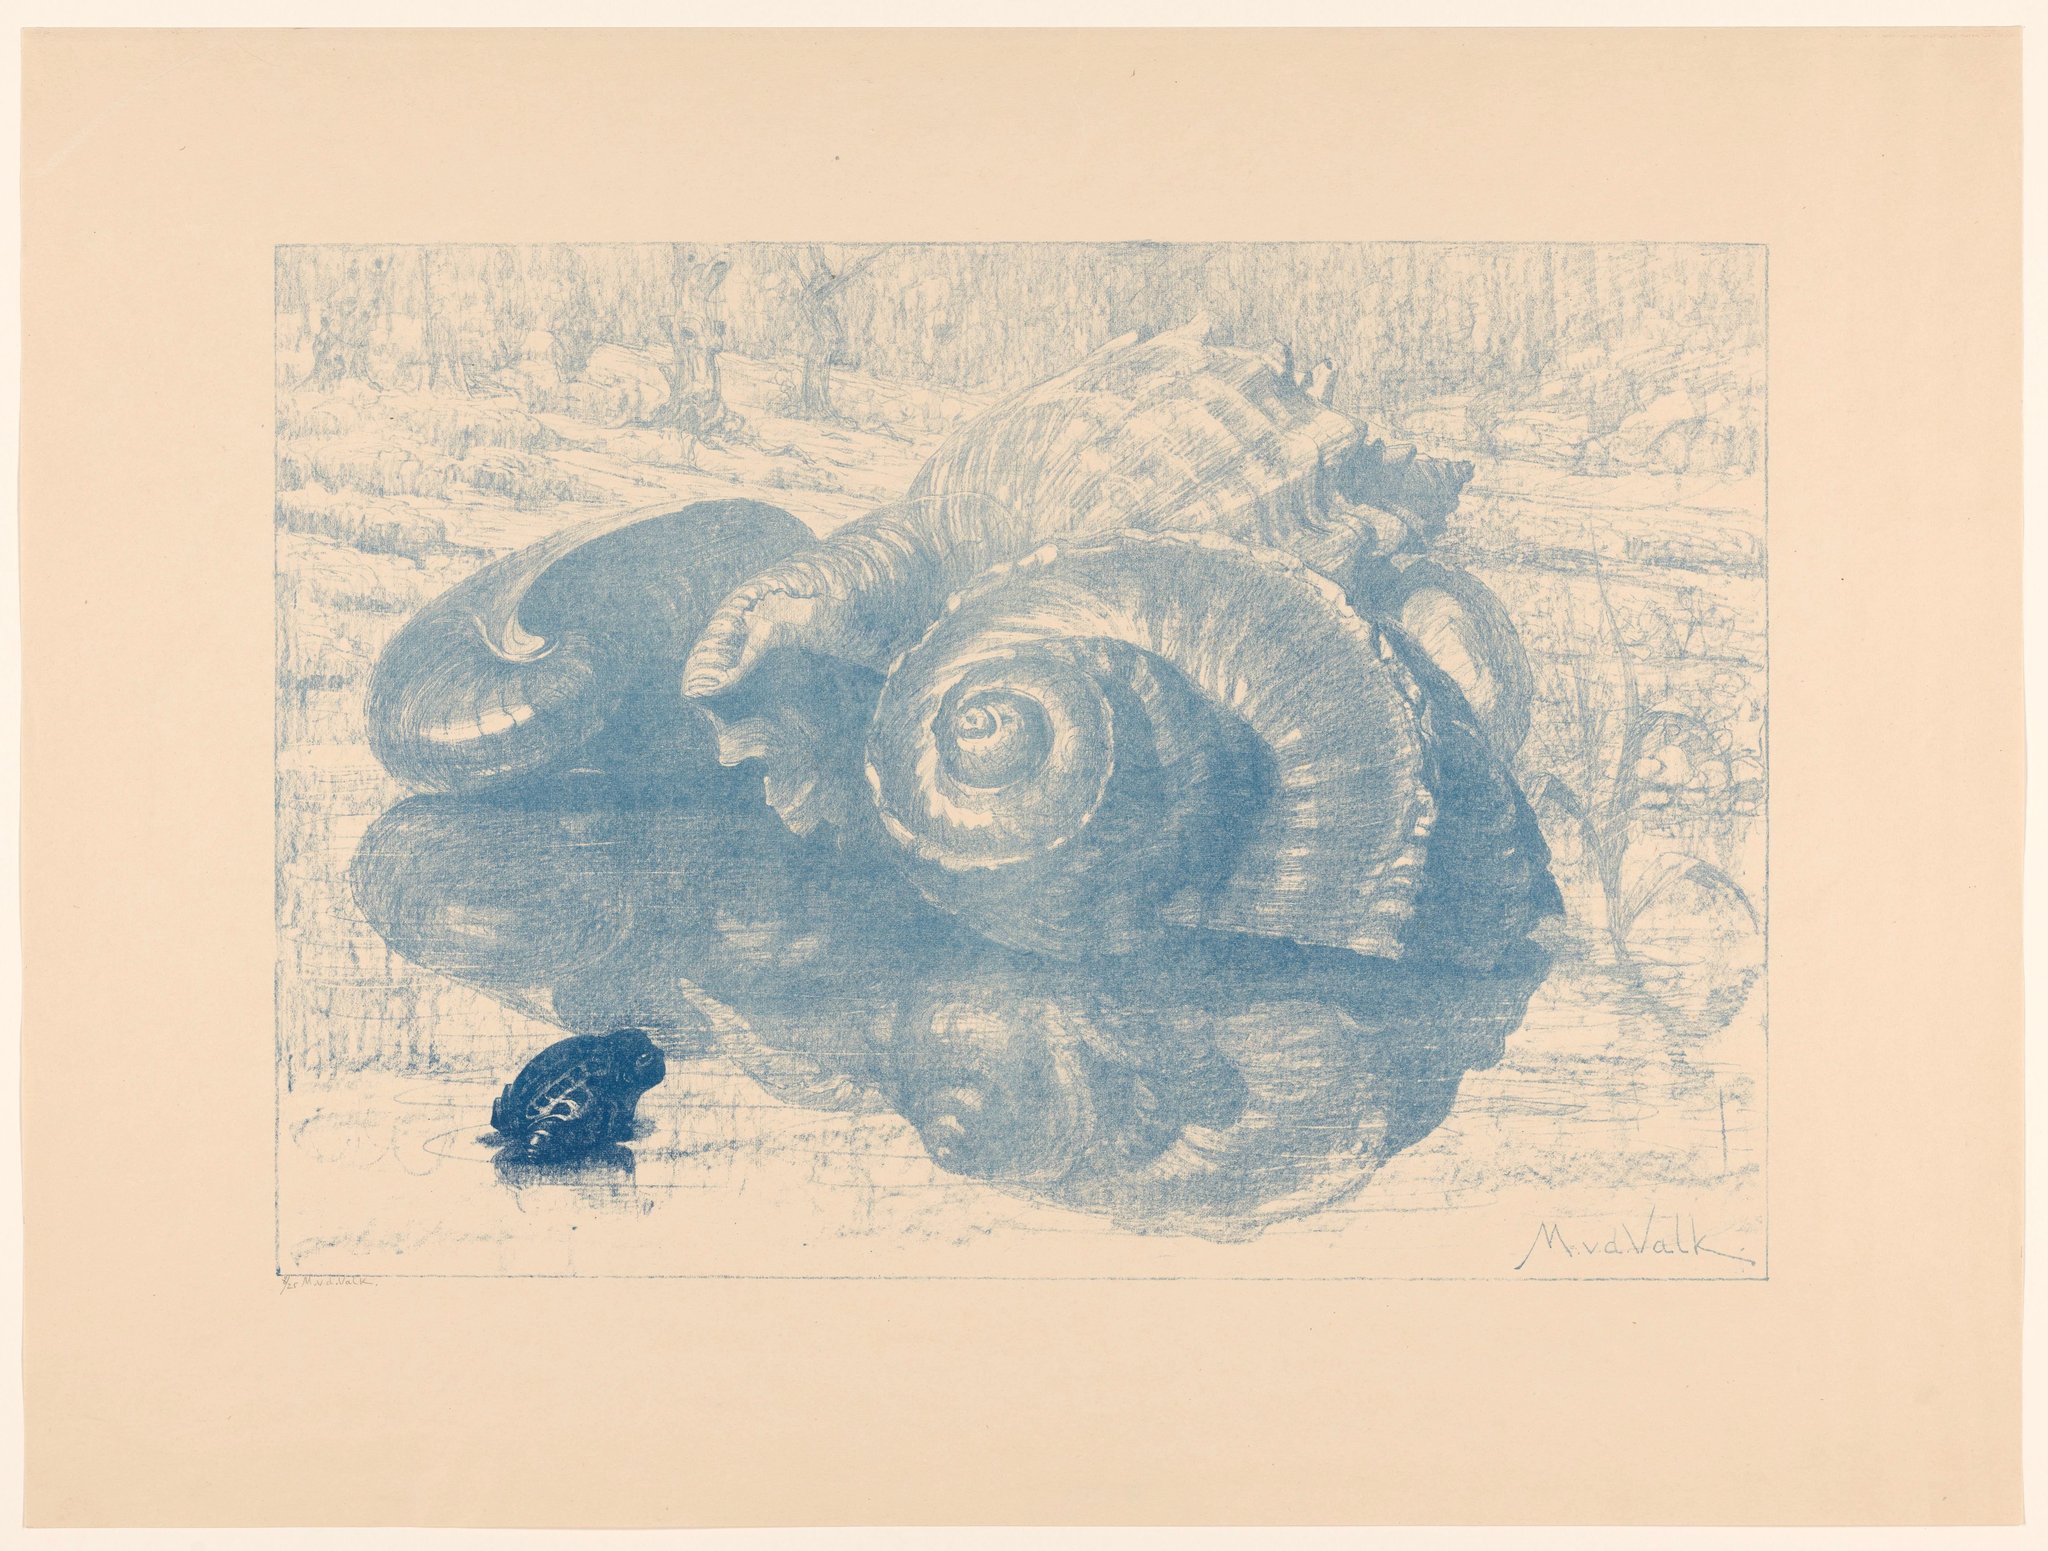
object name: print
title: Slakken en kikkers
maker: maurits van der valk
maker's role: draughtsman, print maker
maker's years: 1857-1935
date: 1884-1935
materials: paper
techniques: lithograph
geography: netherlands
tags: tailless amphibians: frog, molluscs: snail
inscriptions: collector's mark: Lugt 2760, collector's mark: Lugt 2228